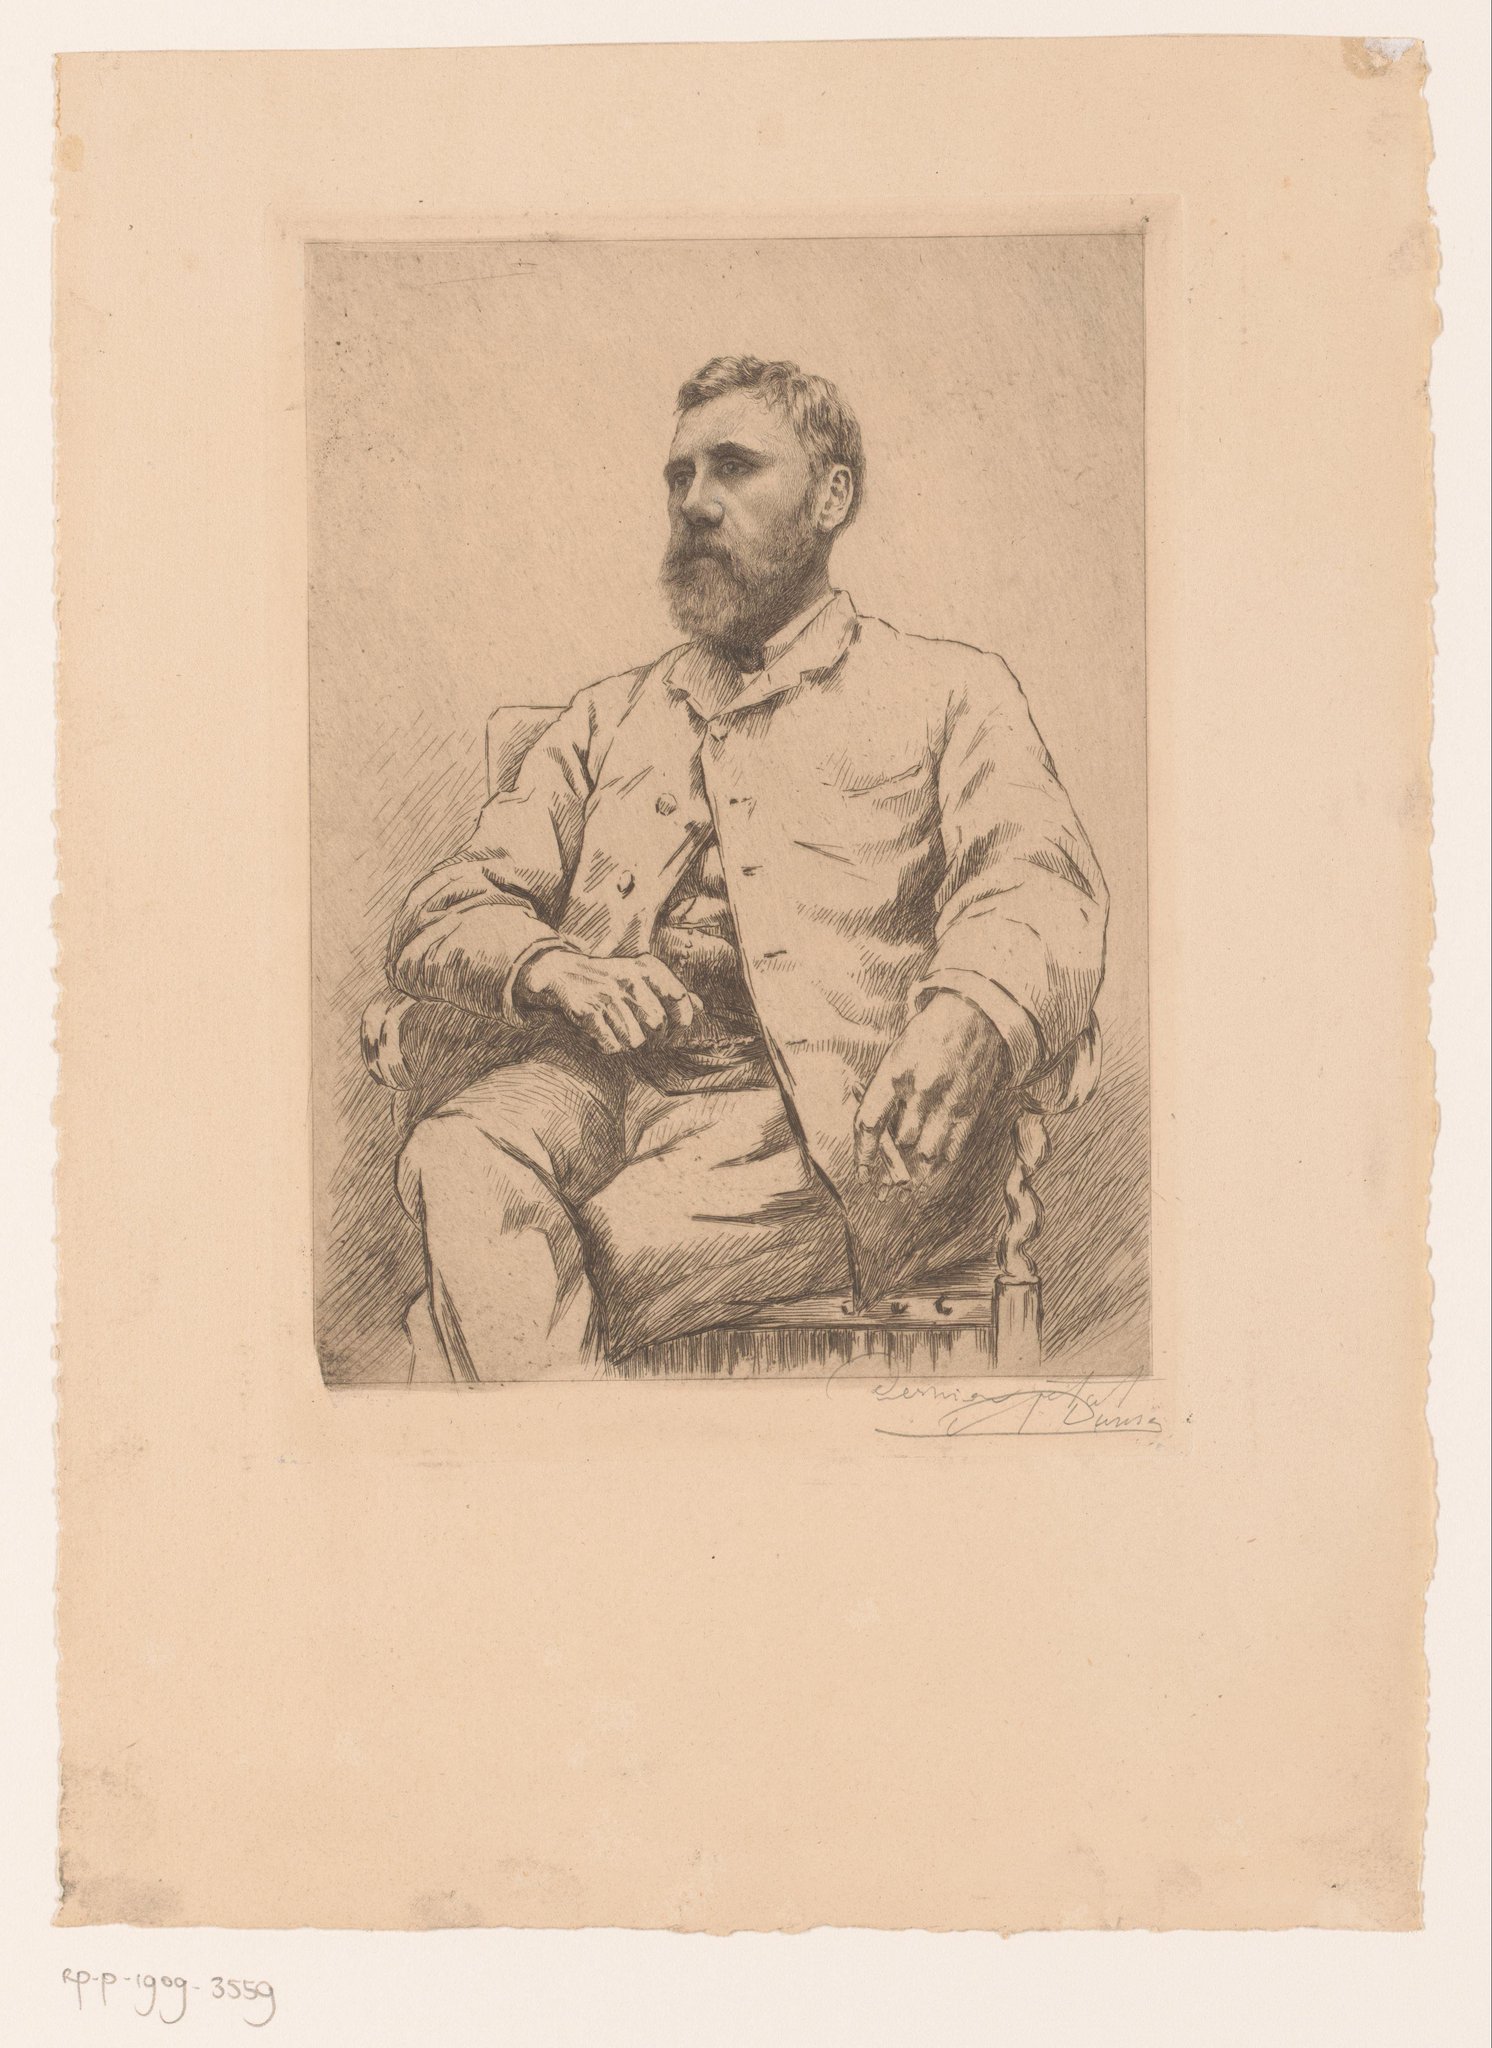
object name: print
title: Portret van een onbekende man, mogelijk ingenieur Honorez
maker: auguste danse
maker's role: print maker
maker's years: 1829-1929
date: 1887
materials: paper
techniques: drypoint, etching, intaglio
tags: anonymous historical person portrayed alone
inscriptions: annotation: ‘Dernier état’, collector's mark: Lugt 2228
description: De naam Honorez wordt genoemd in een potloodaantekening op een eerdere staat van deze prent.